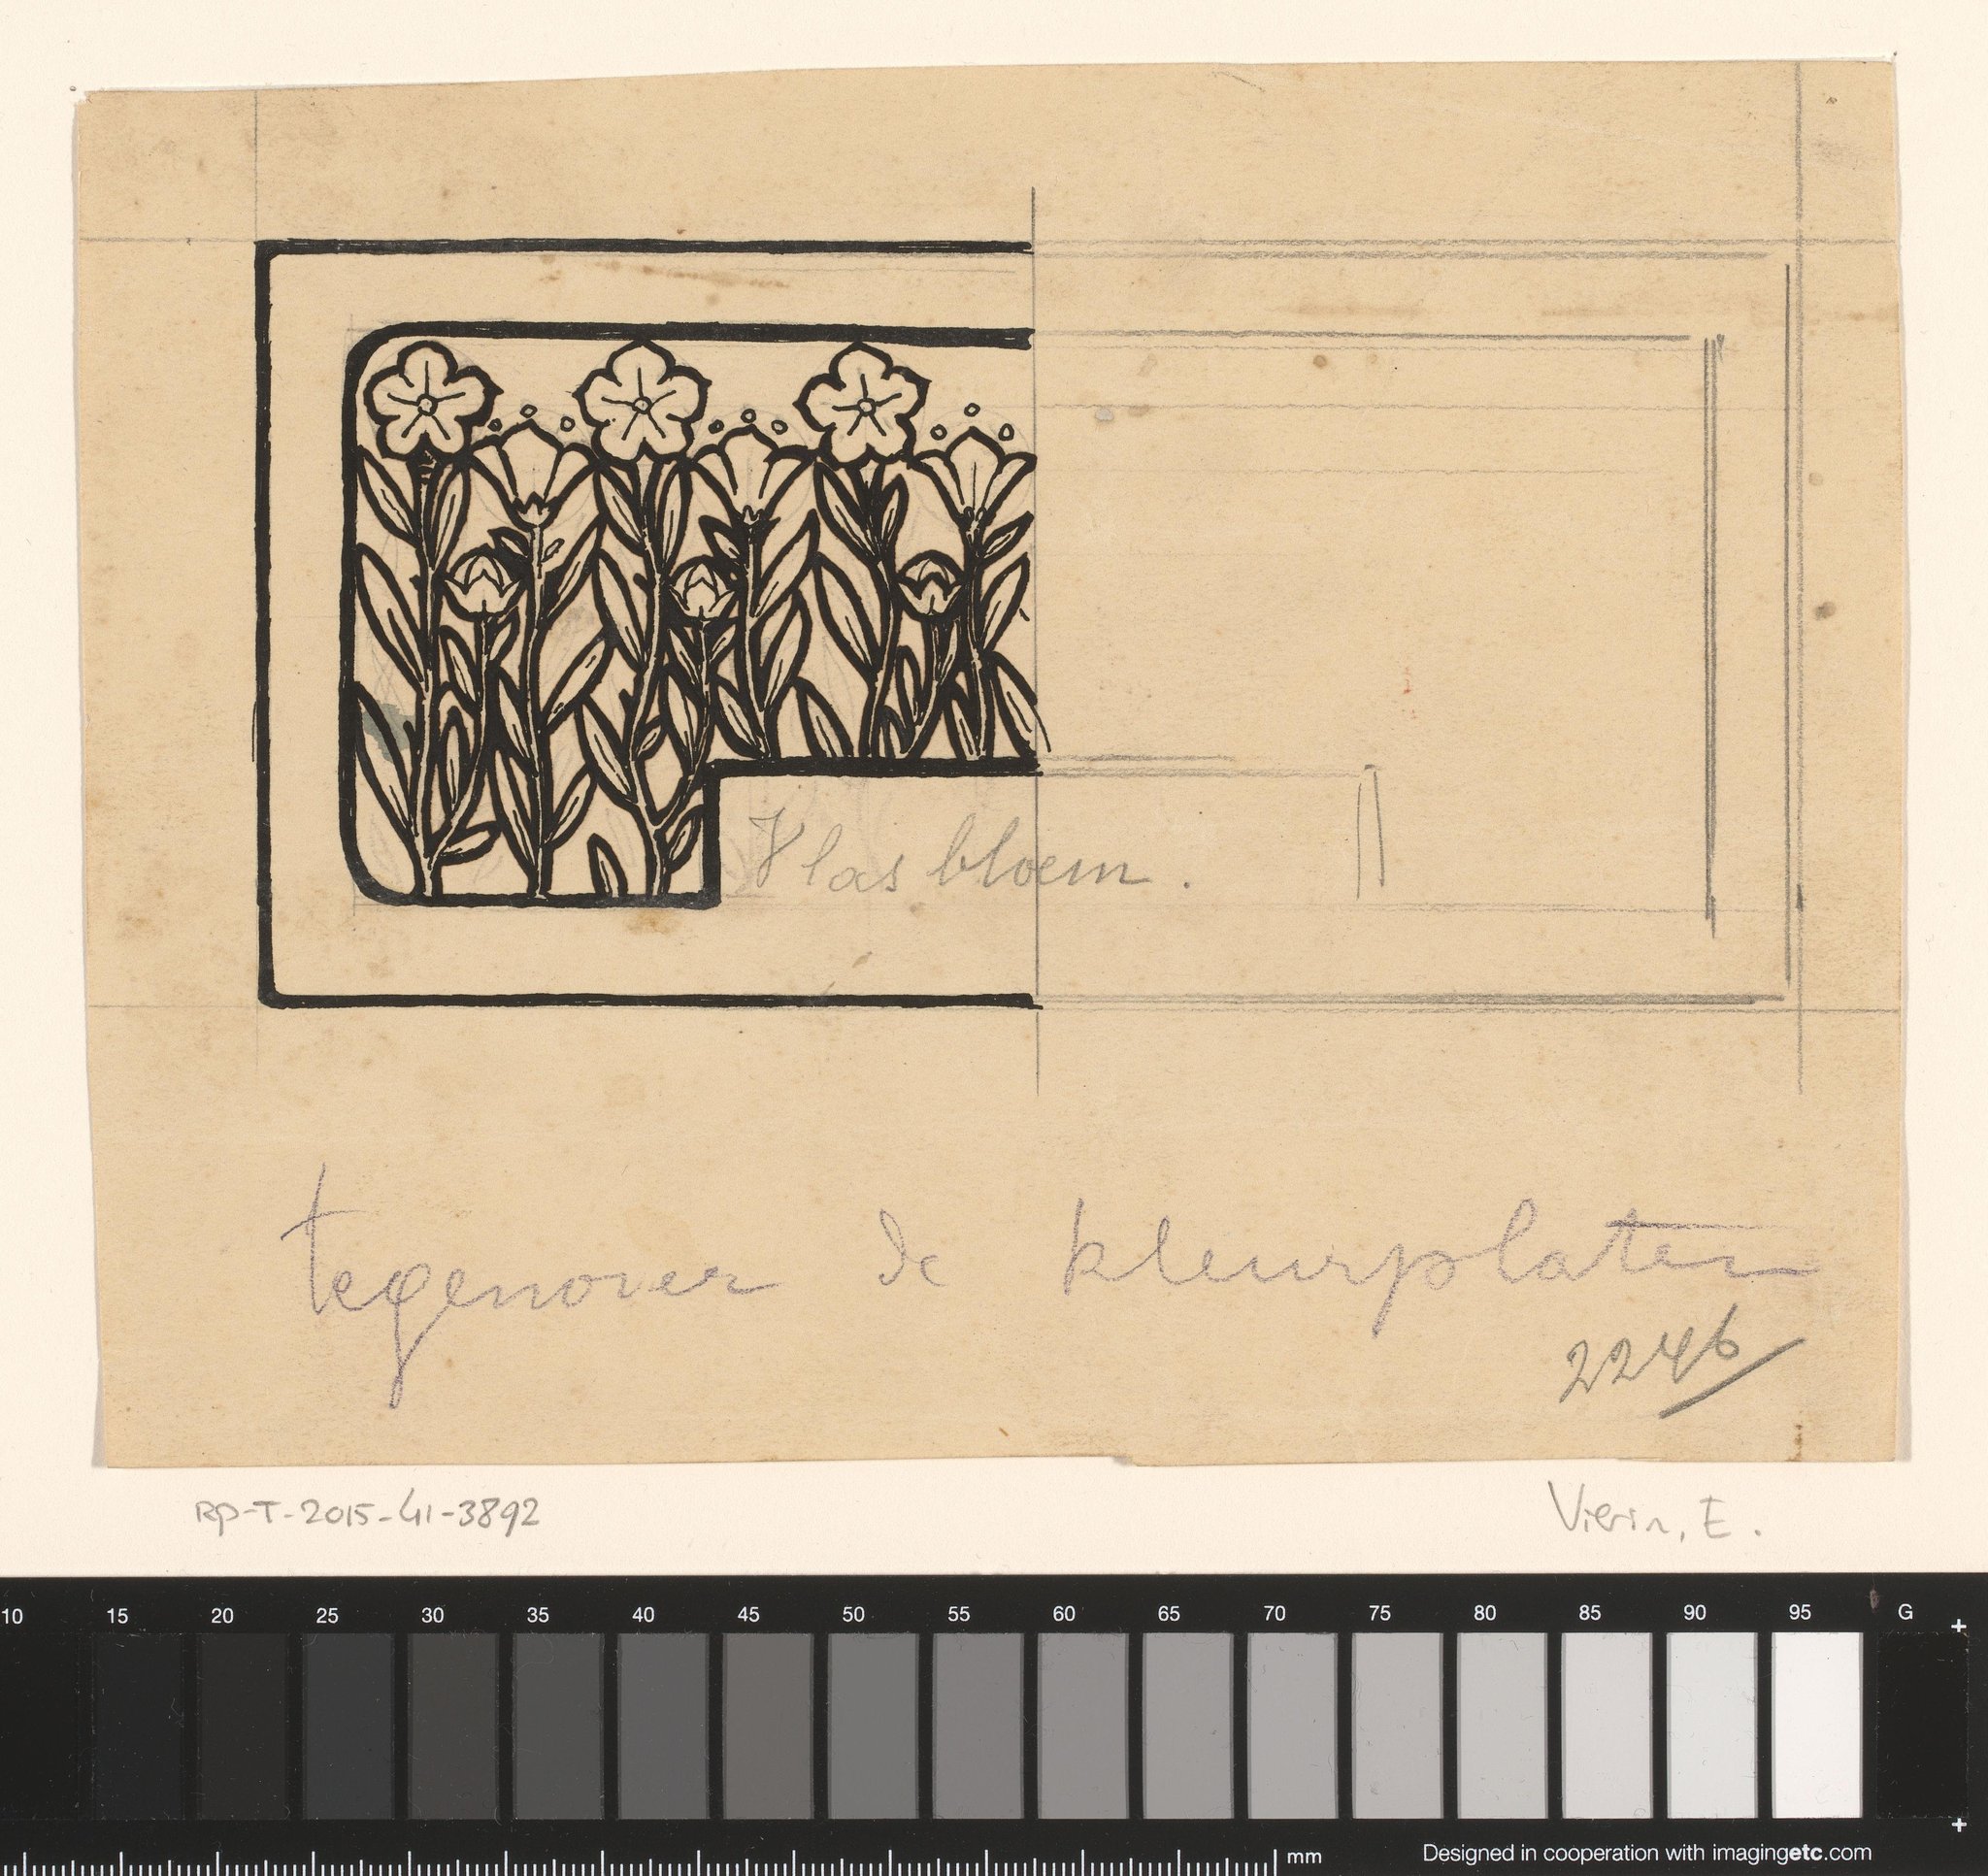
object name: drawing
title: Vlasbloemen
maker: emmanuel viérin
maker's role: draughtsman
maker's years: 1869-1954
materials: ink, paper, pencil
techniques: pen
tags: flowers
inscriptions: annotation: ‘Vlasbloem./ tegenover de kleurplaten’, :, collector's mark: Lugt 2228a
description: Ontwerp voor: Streuvels, Stijn. De vlaschaard. Amsterdam: Veen, 1907.